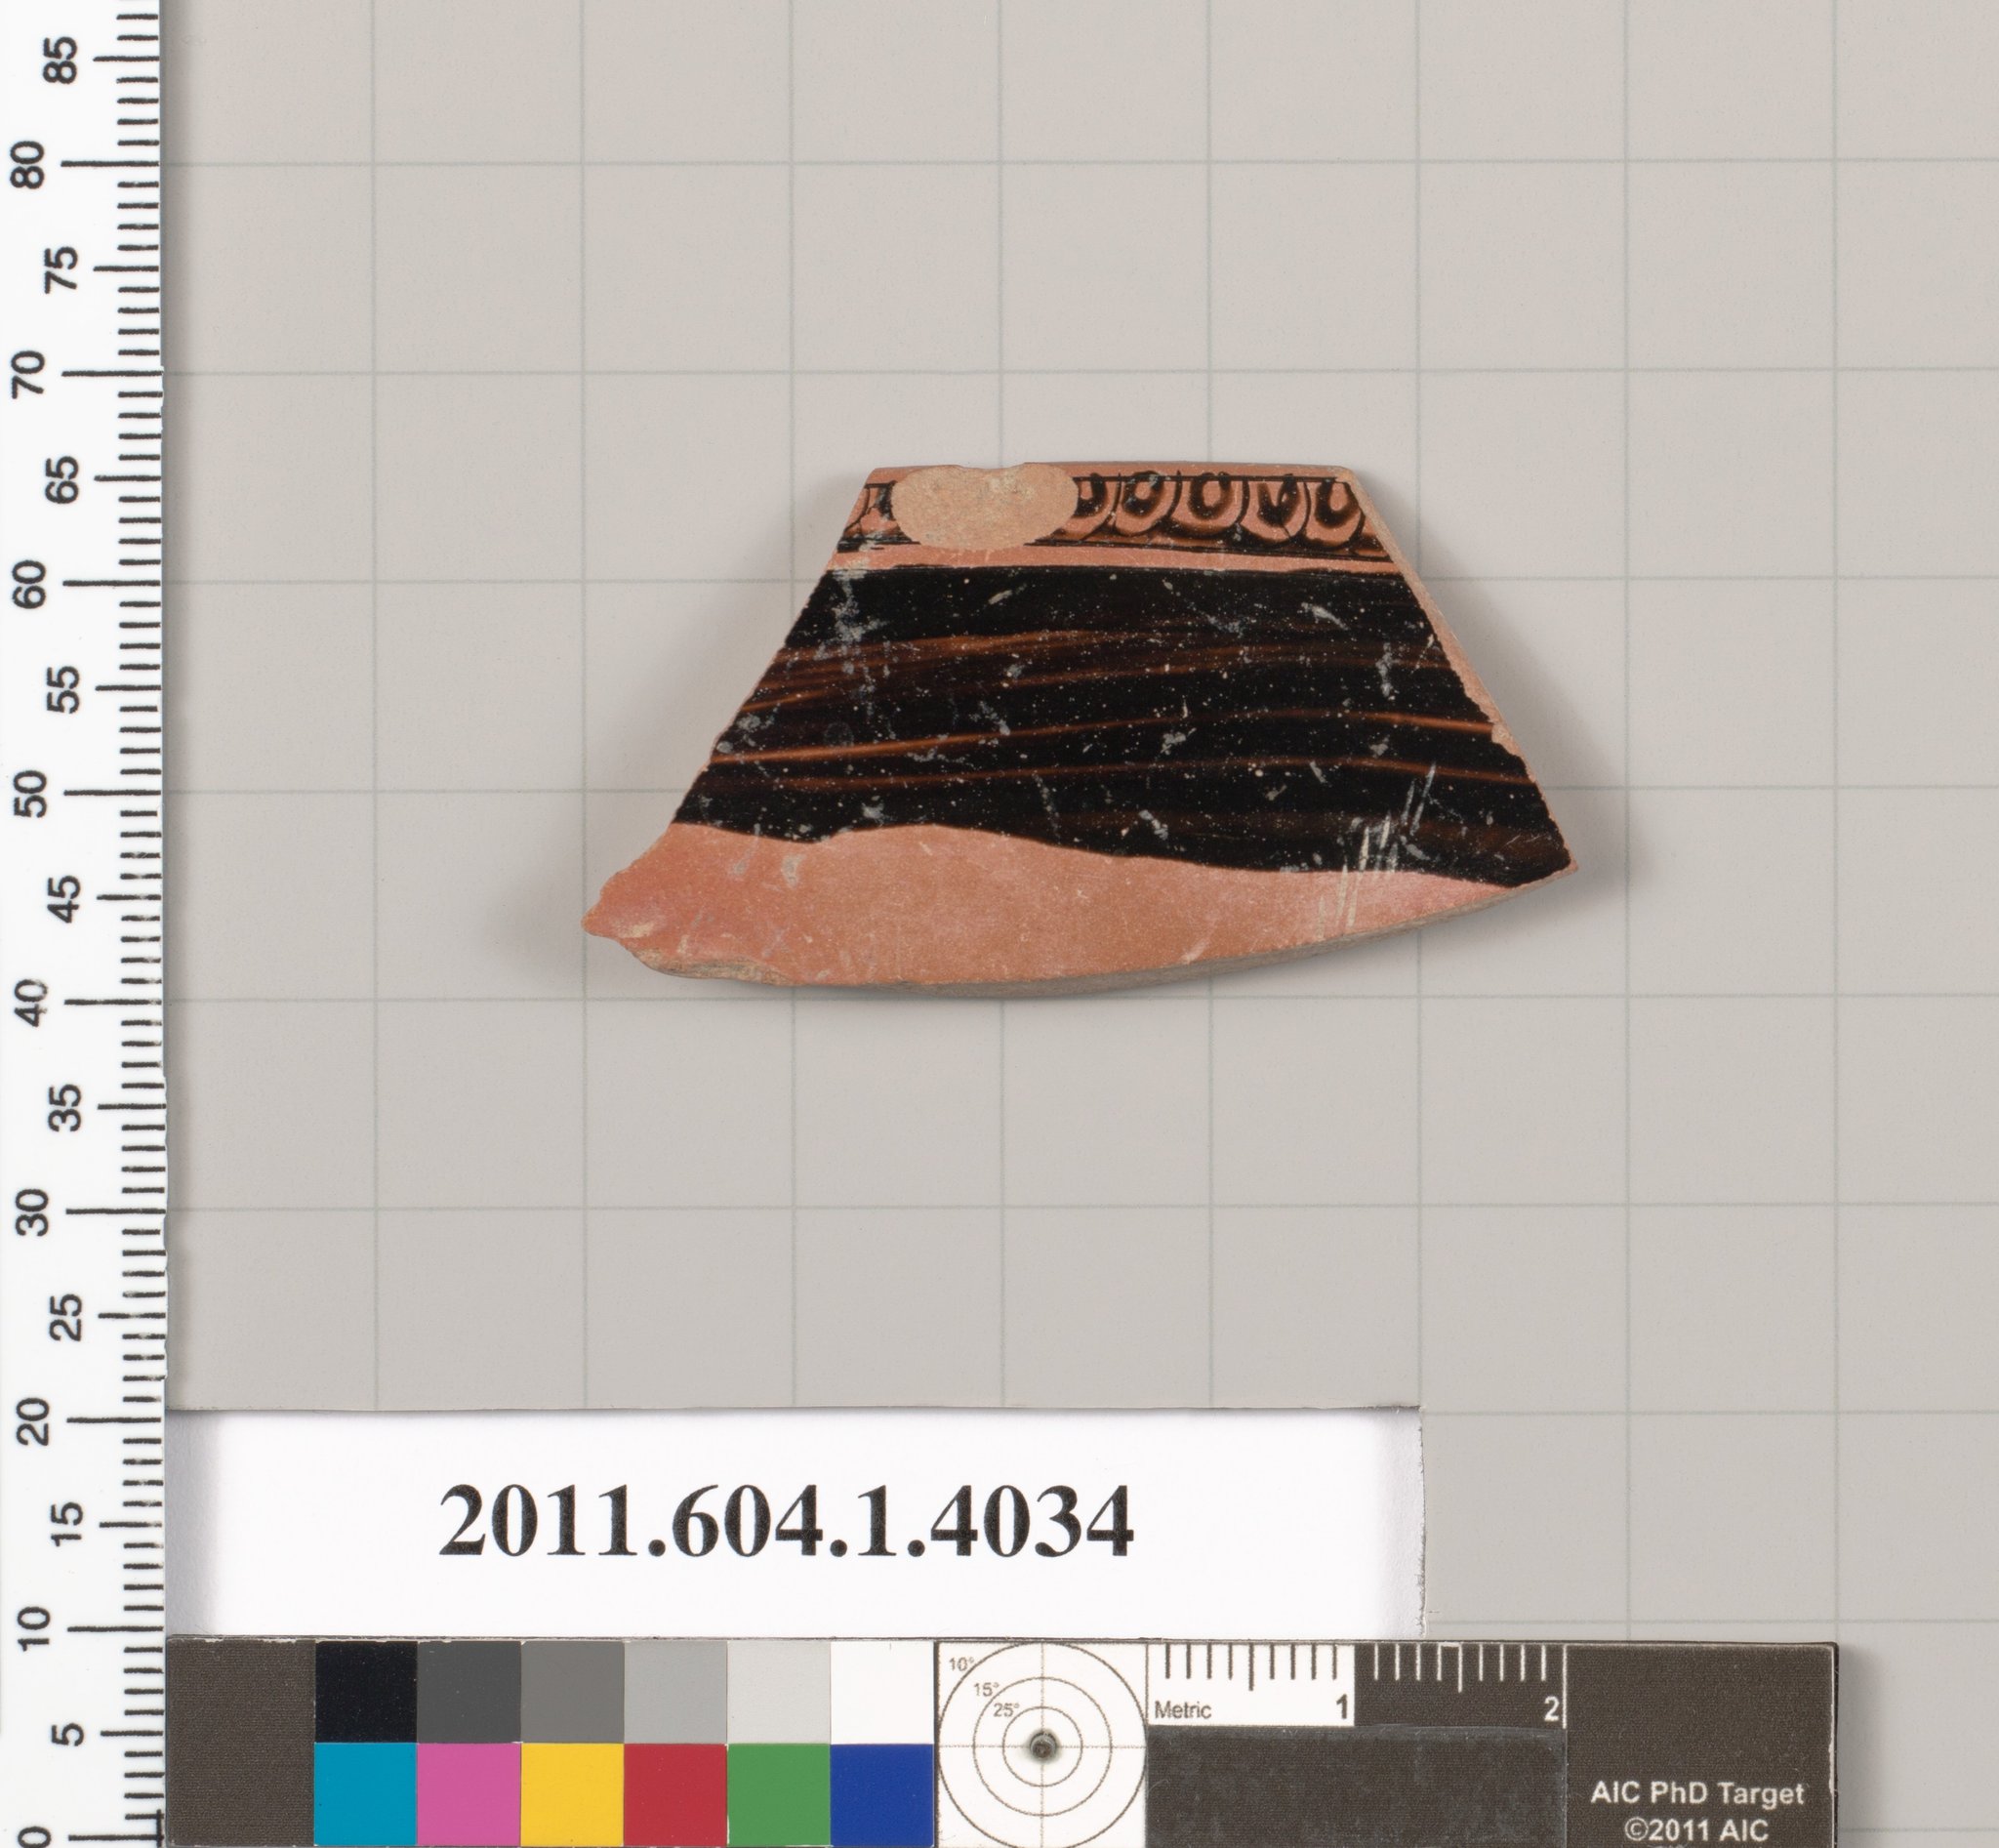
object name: kylix fragment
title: Terracotta rim fragment of a kylix (drinking cup)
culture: greek, attic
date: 460-440 BCE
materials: terracotta